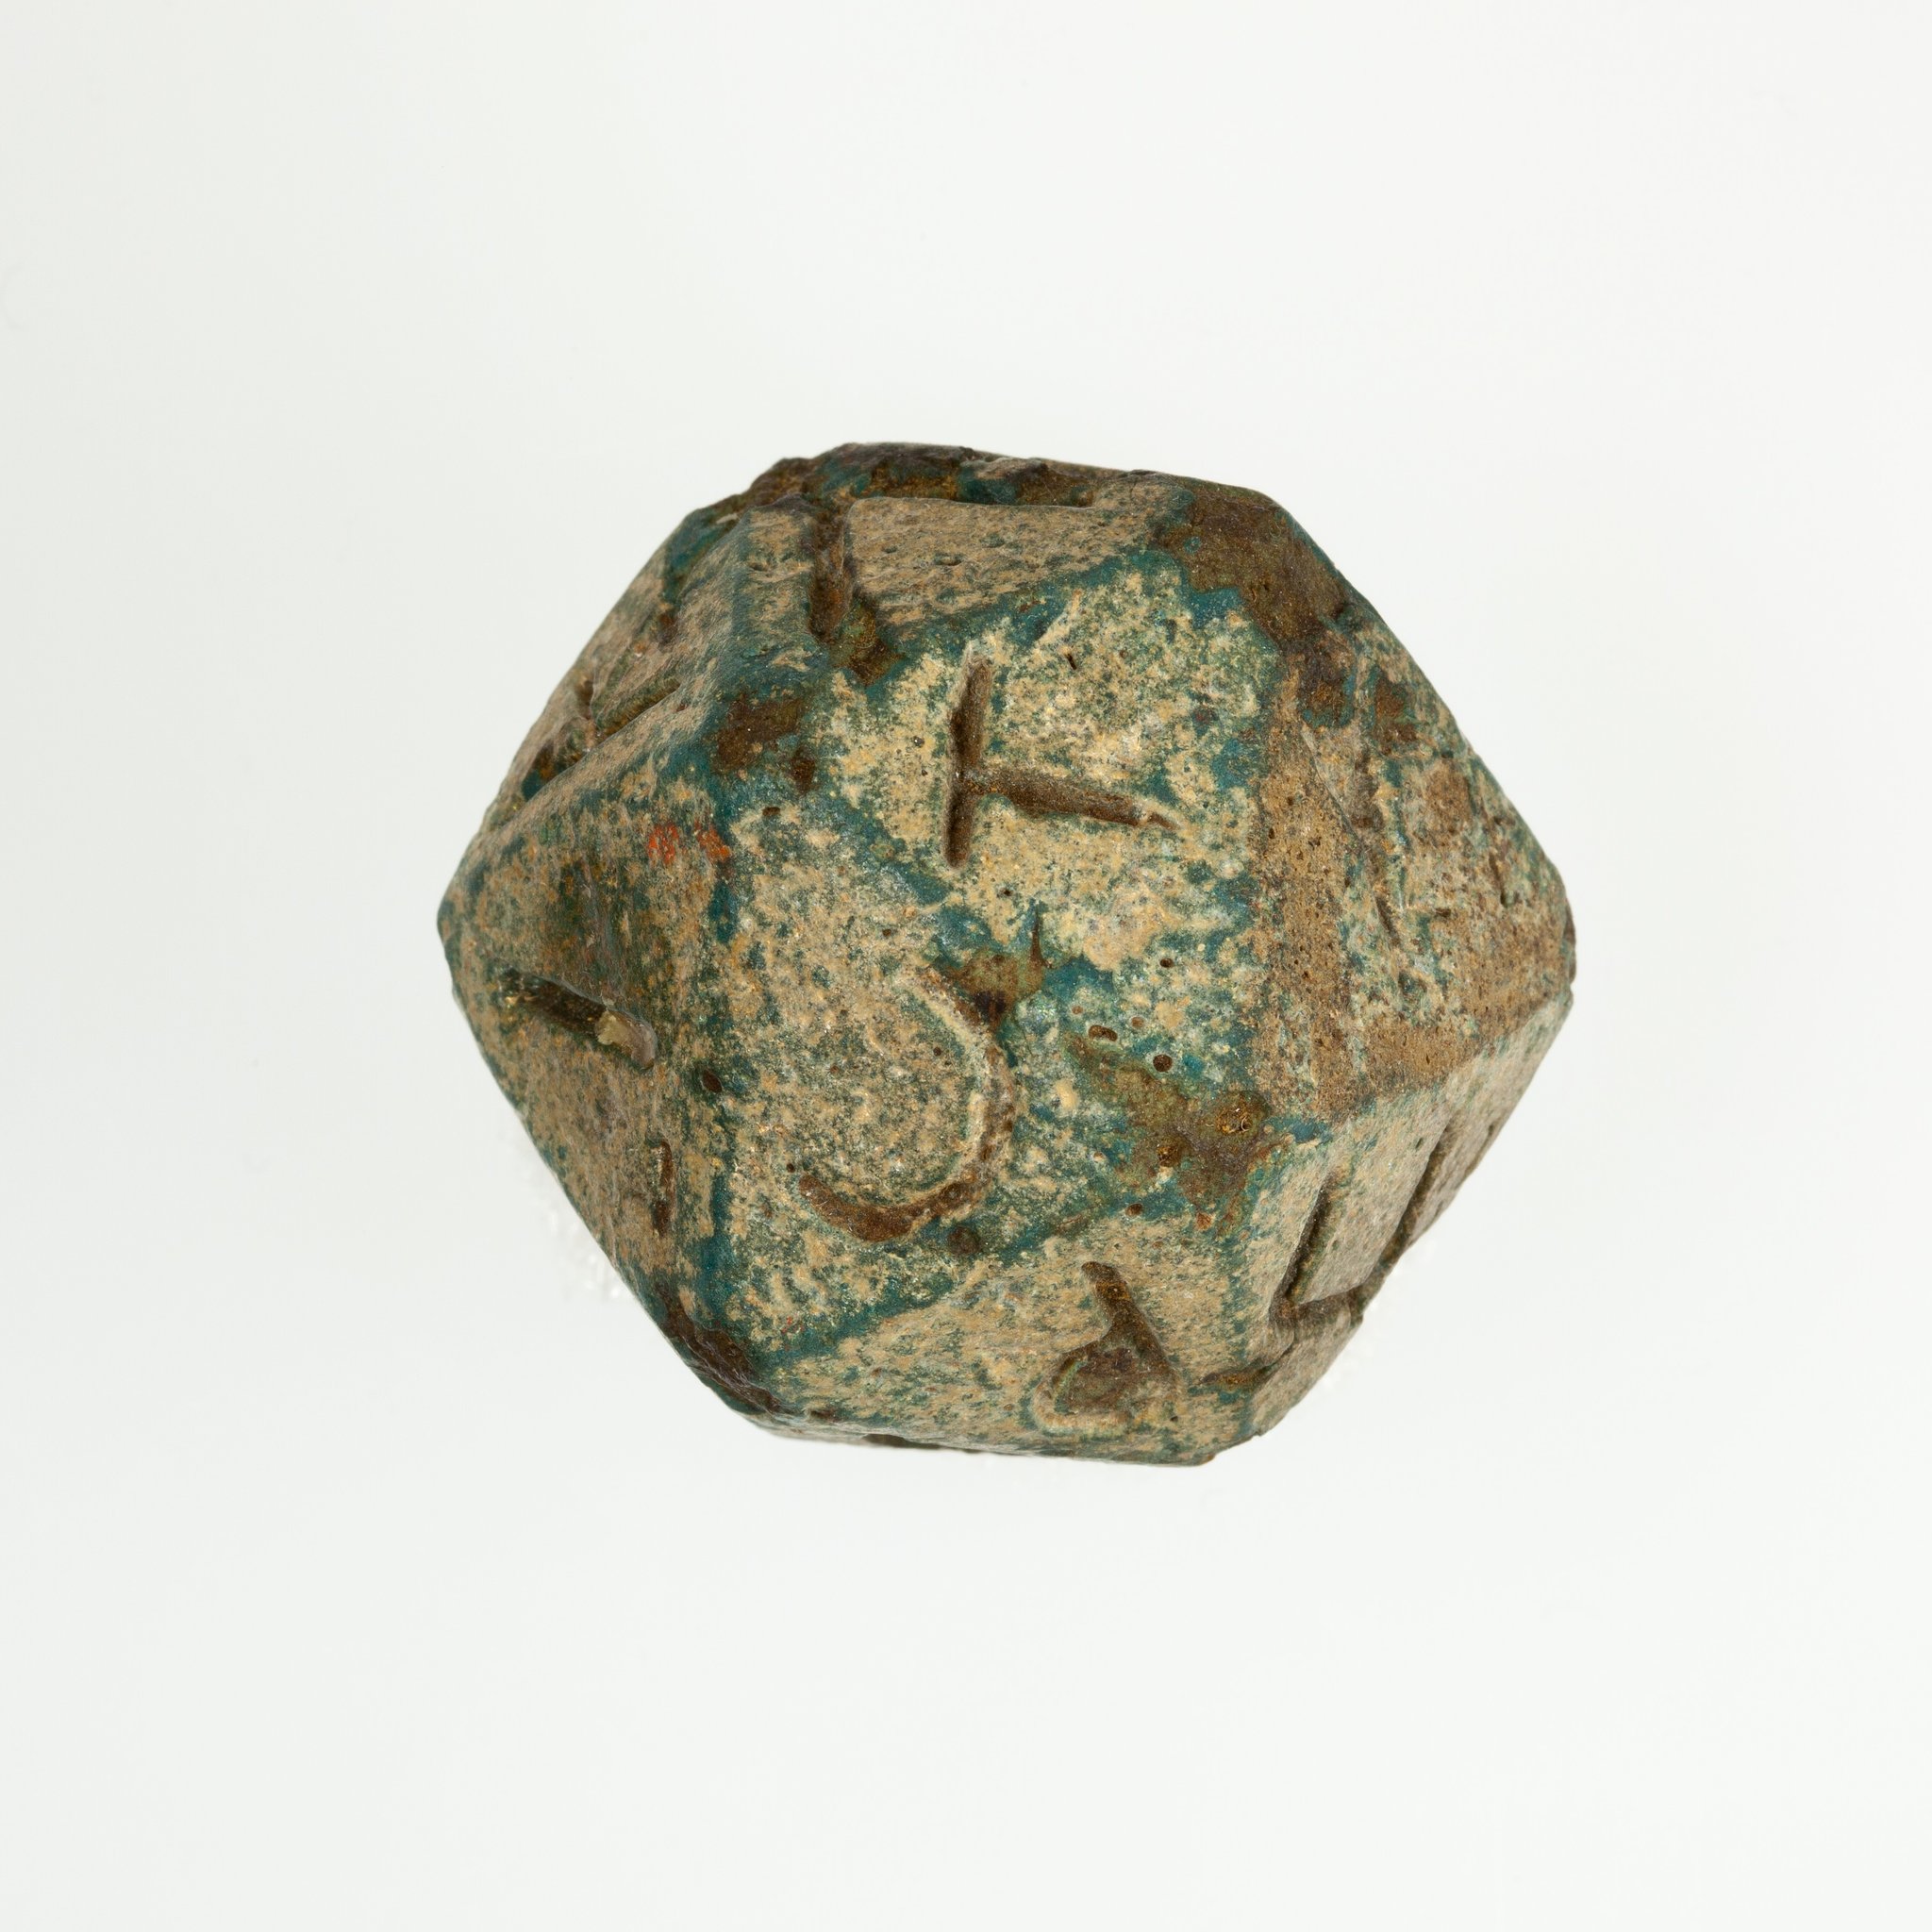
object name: die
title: Twenty-sided die (icosahedron) with faces inscribed with Greek letters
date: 200 BCE-400 CE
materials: faience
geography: egypt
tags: dice